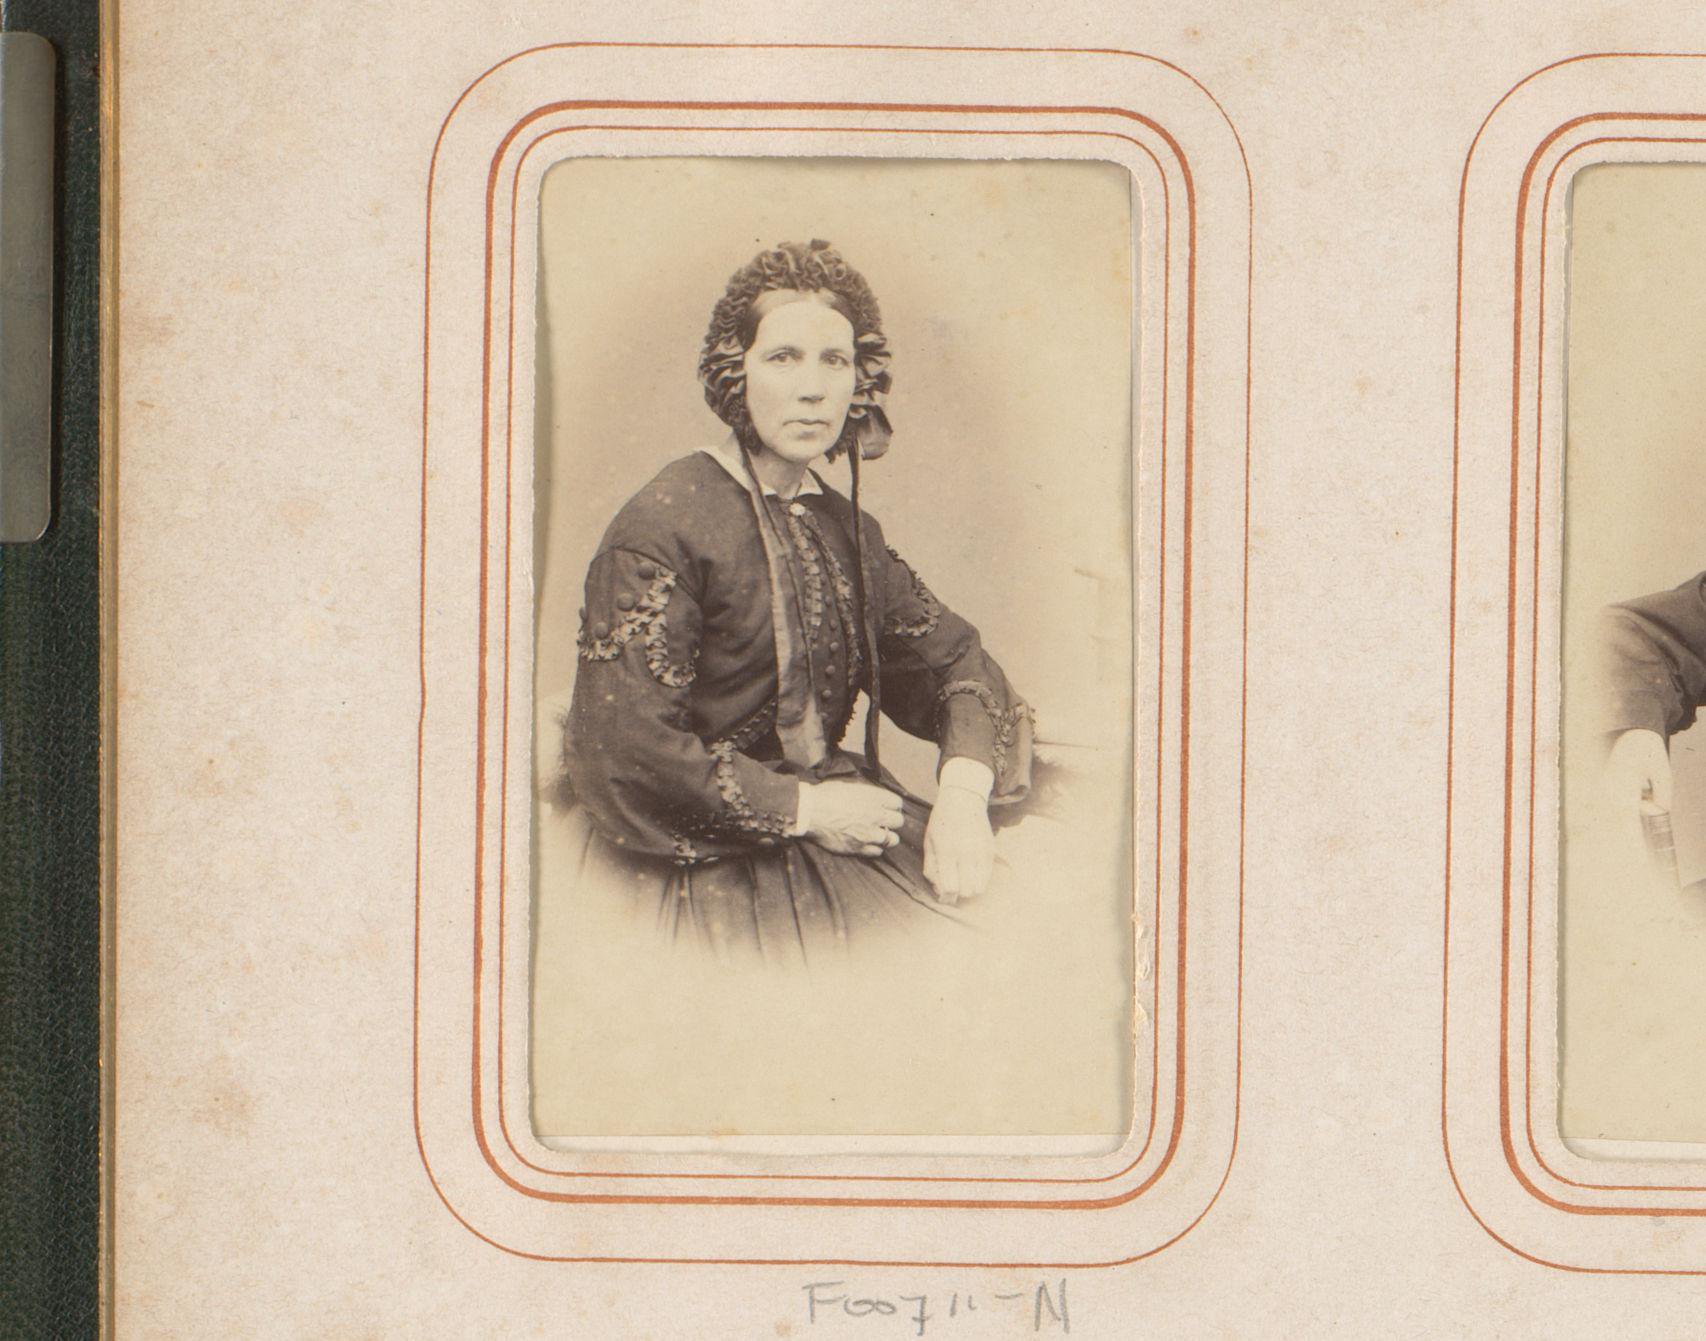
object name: photograph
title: Portret van een vrouw met muts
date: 1868-1869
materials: cardboard, photographic support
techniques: albumen print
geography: rotterdam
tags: historical persons - bb - woman, head-gear: cap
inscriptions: inscription: ‘Photographisch Atelier/ C. Janssens & E. Radermacher/ Nieuwe Veemarkt 14-341/ Rotterdam’